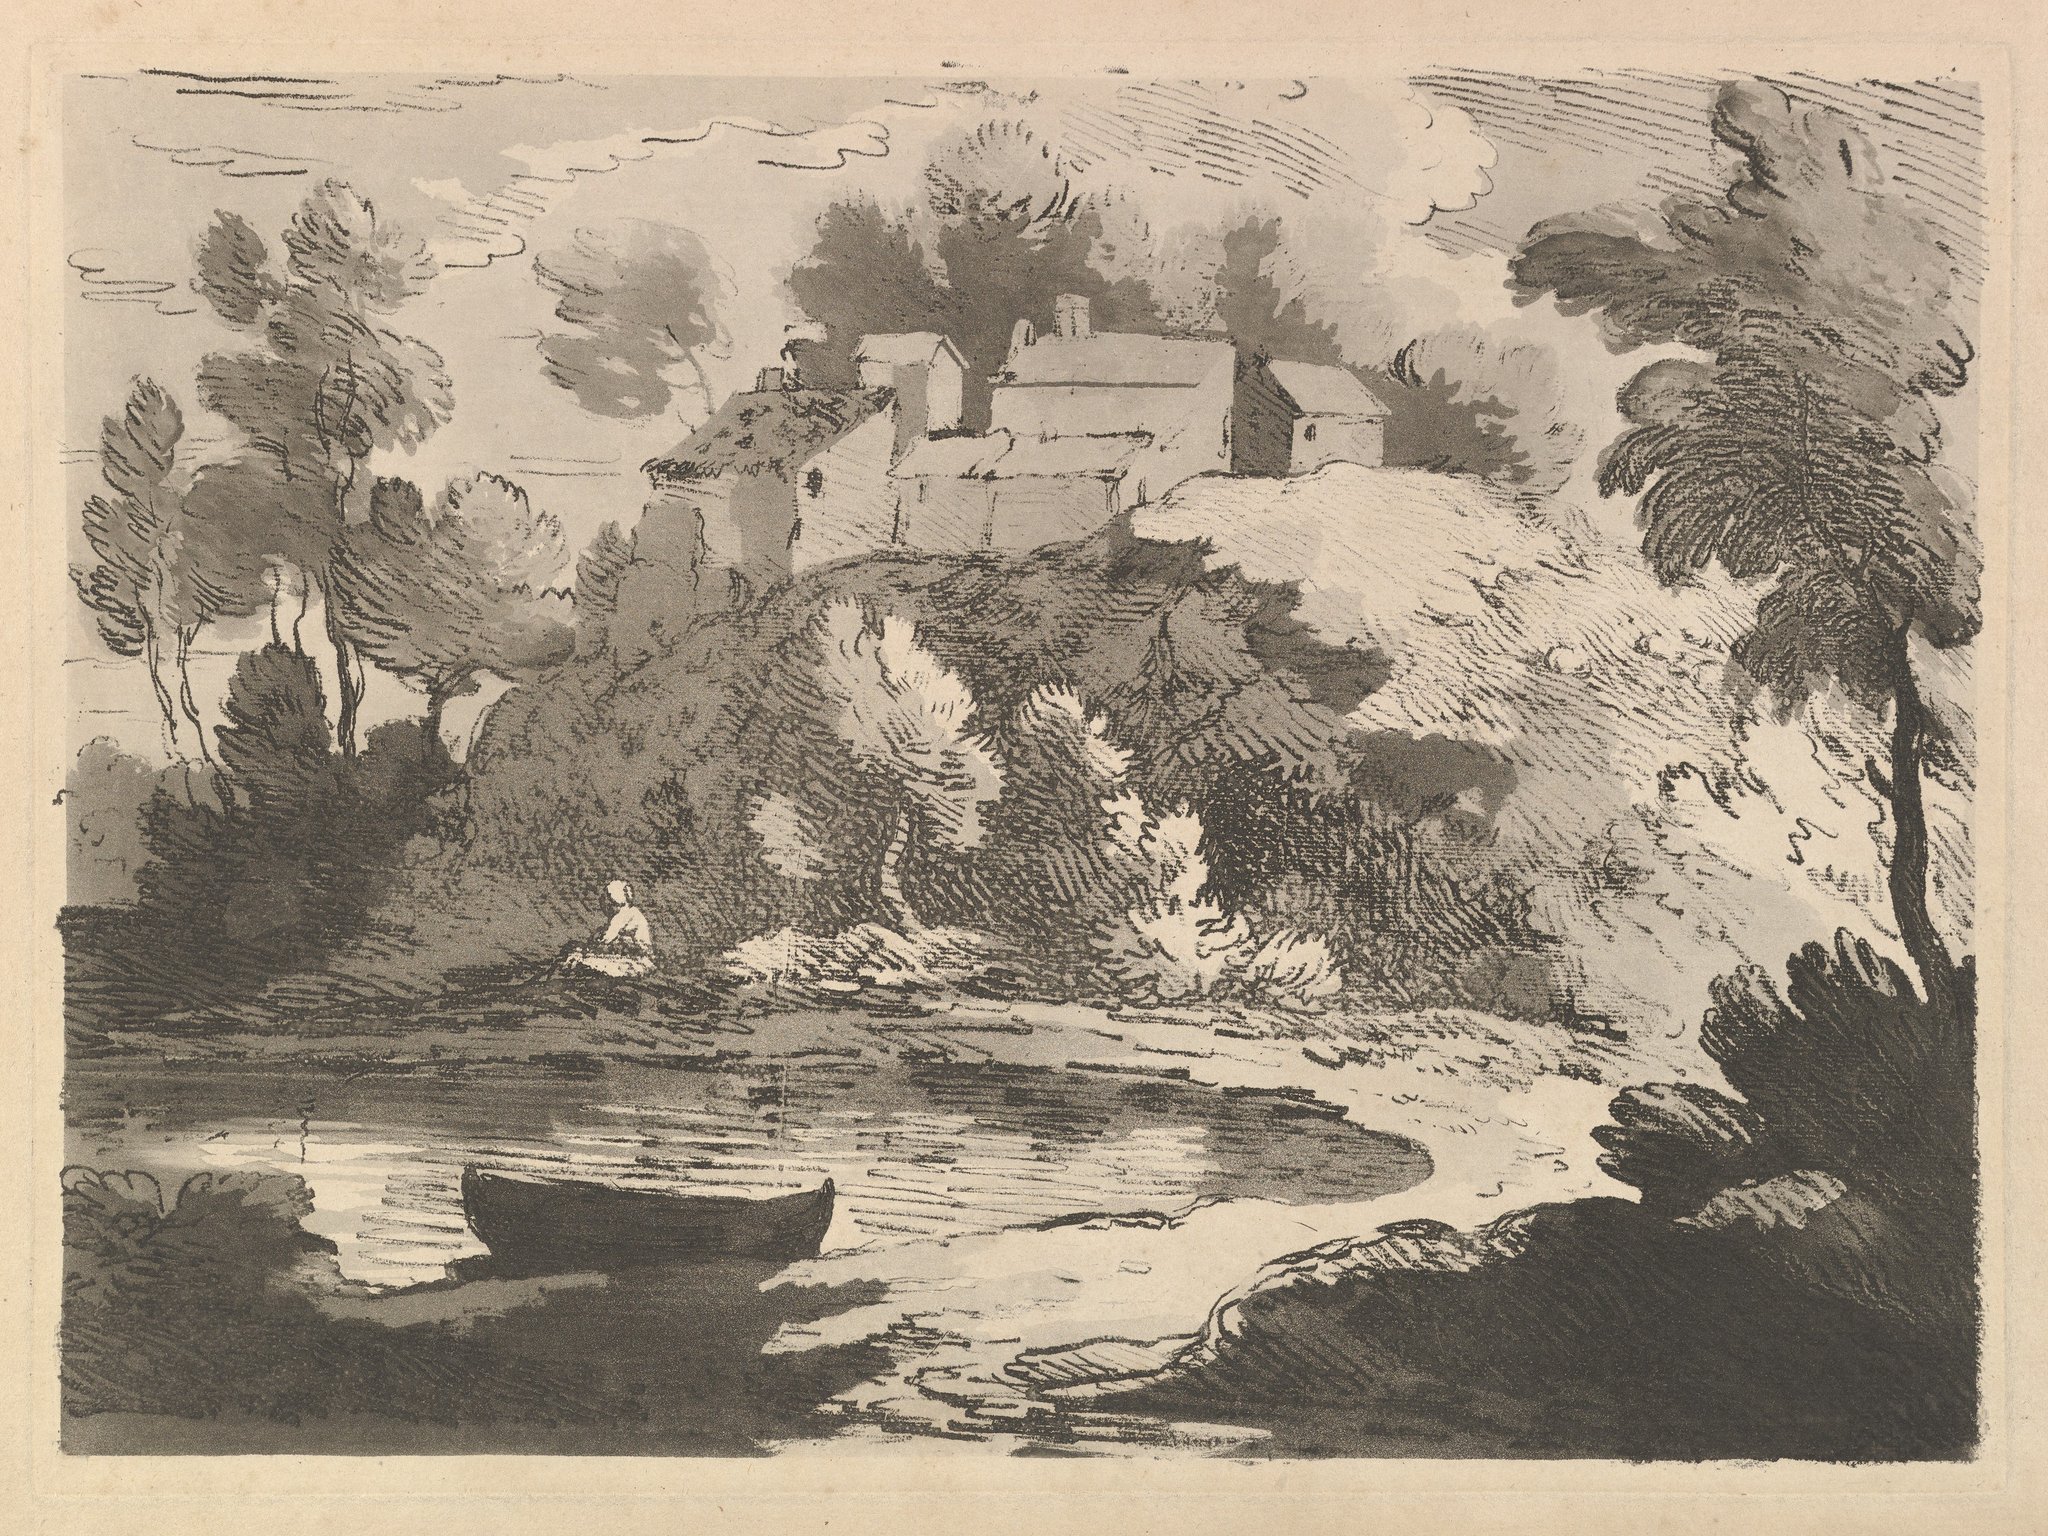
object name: print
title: Hilly River Landscape, a Boat in the Water at Foreground Left, a Figure on the Far Shore, Houses on a Wooded Hill Beyond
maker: thomas rowlandson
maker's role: artist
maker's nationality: british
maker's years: 1757-1827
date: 1783-1784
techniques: aquatint, etching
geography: england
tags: houses,rivers,landscapes,boats